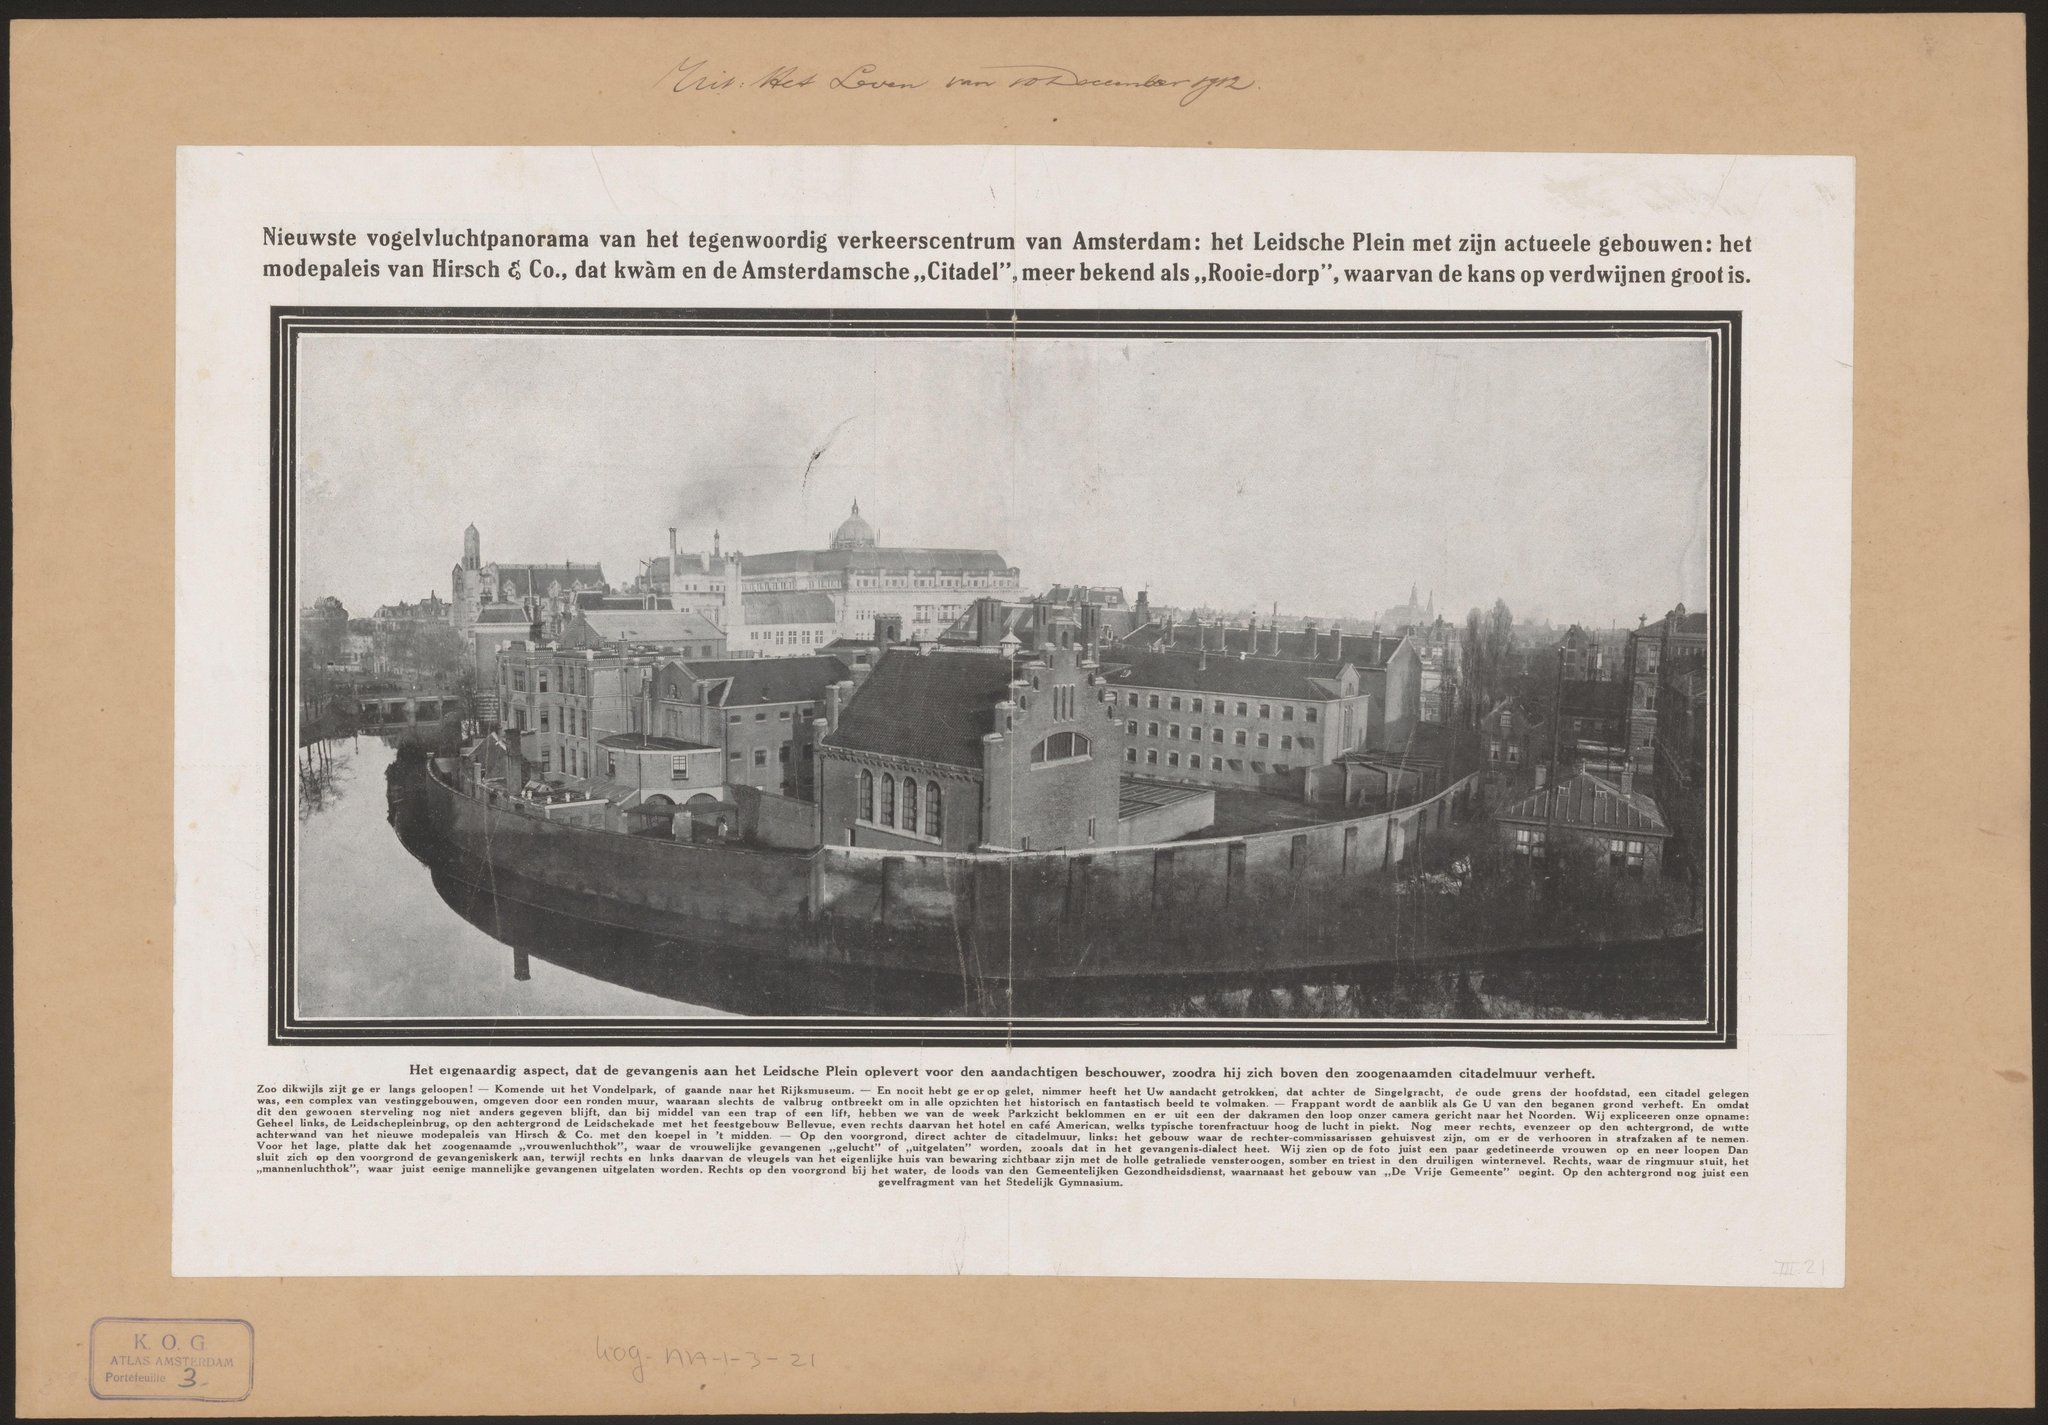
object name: photomechanical print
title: Gezicht op de gevangenis aan het Leidseplein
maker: Anonymous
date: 1912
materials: paper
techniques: letterpress printing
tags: prison, jail, canal, prospect of city, town panorama, silhouette of city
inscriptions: collector's mark: ‘3’ Lugt 1641b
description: Fotomechanische afdruk uit: Het Leven. Geïllustreerd (1912), 10 december 1912.